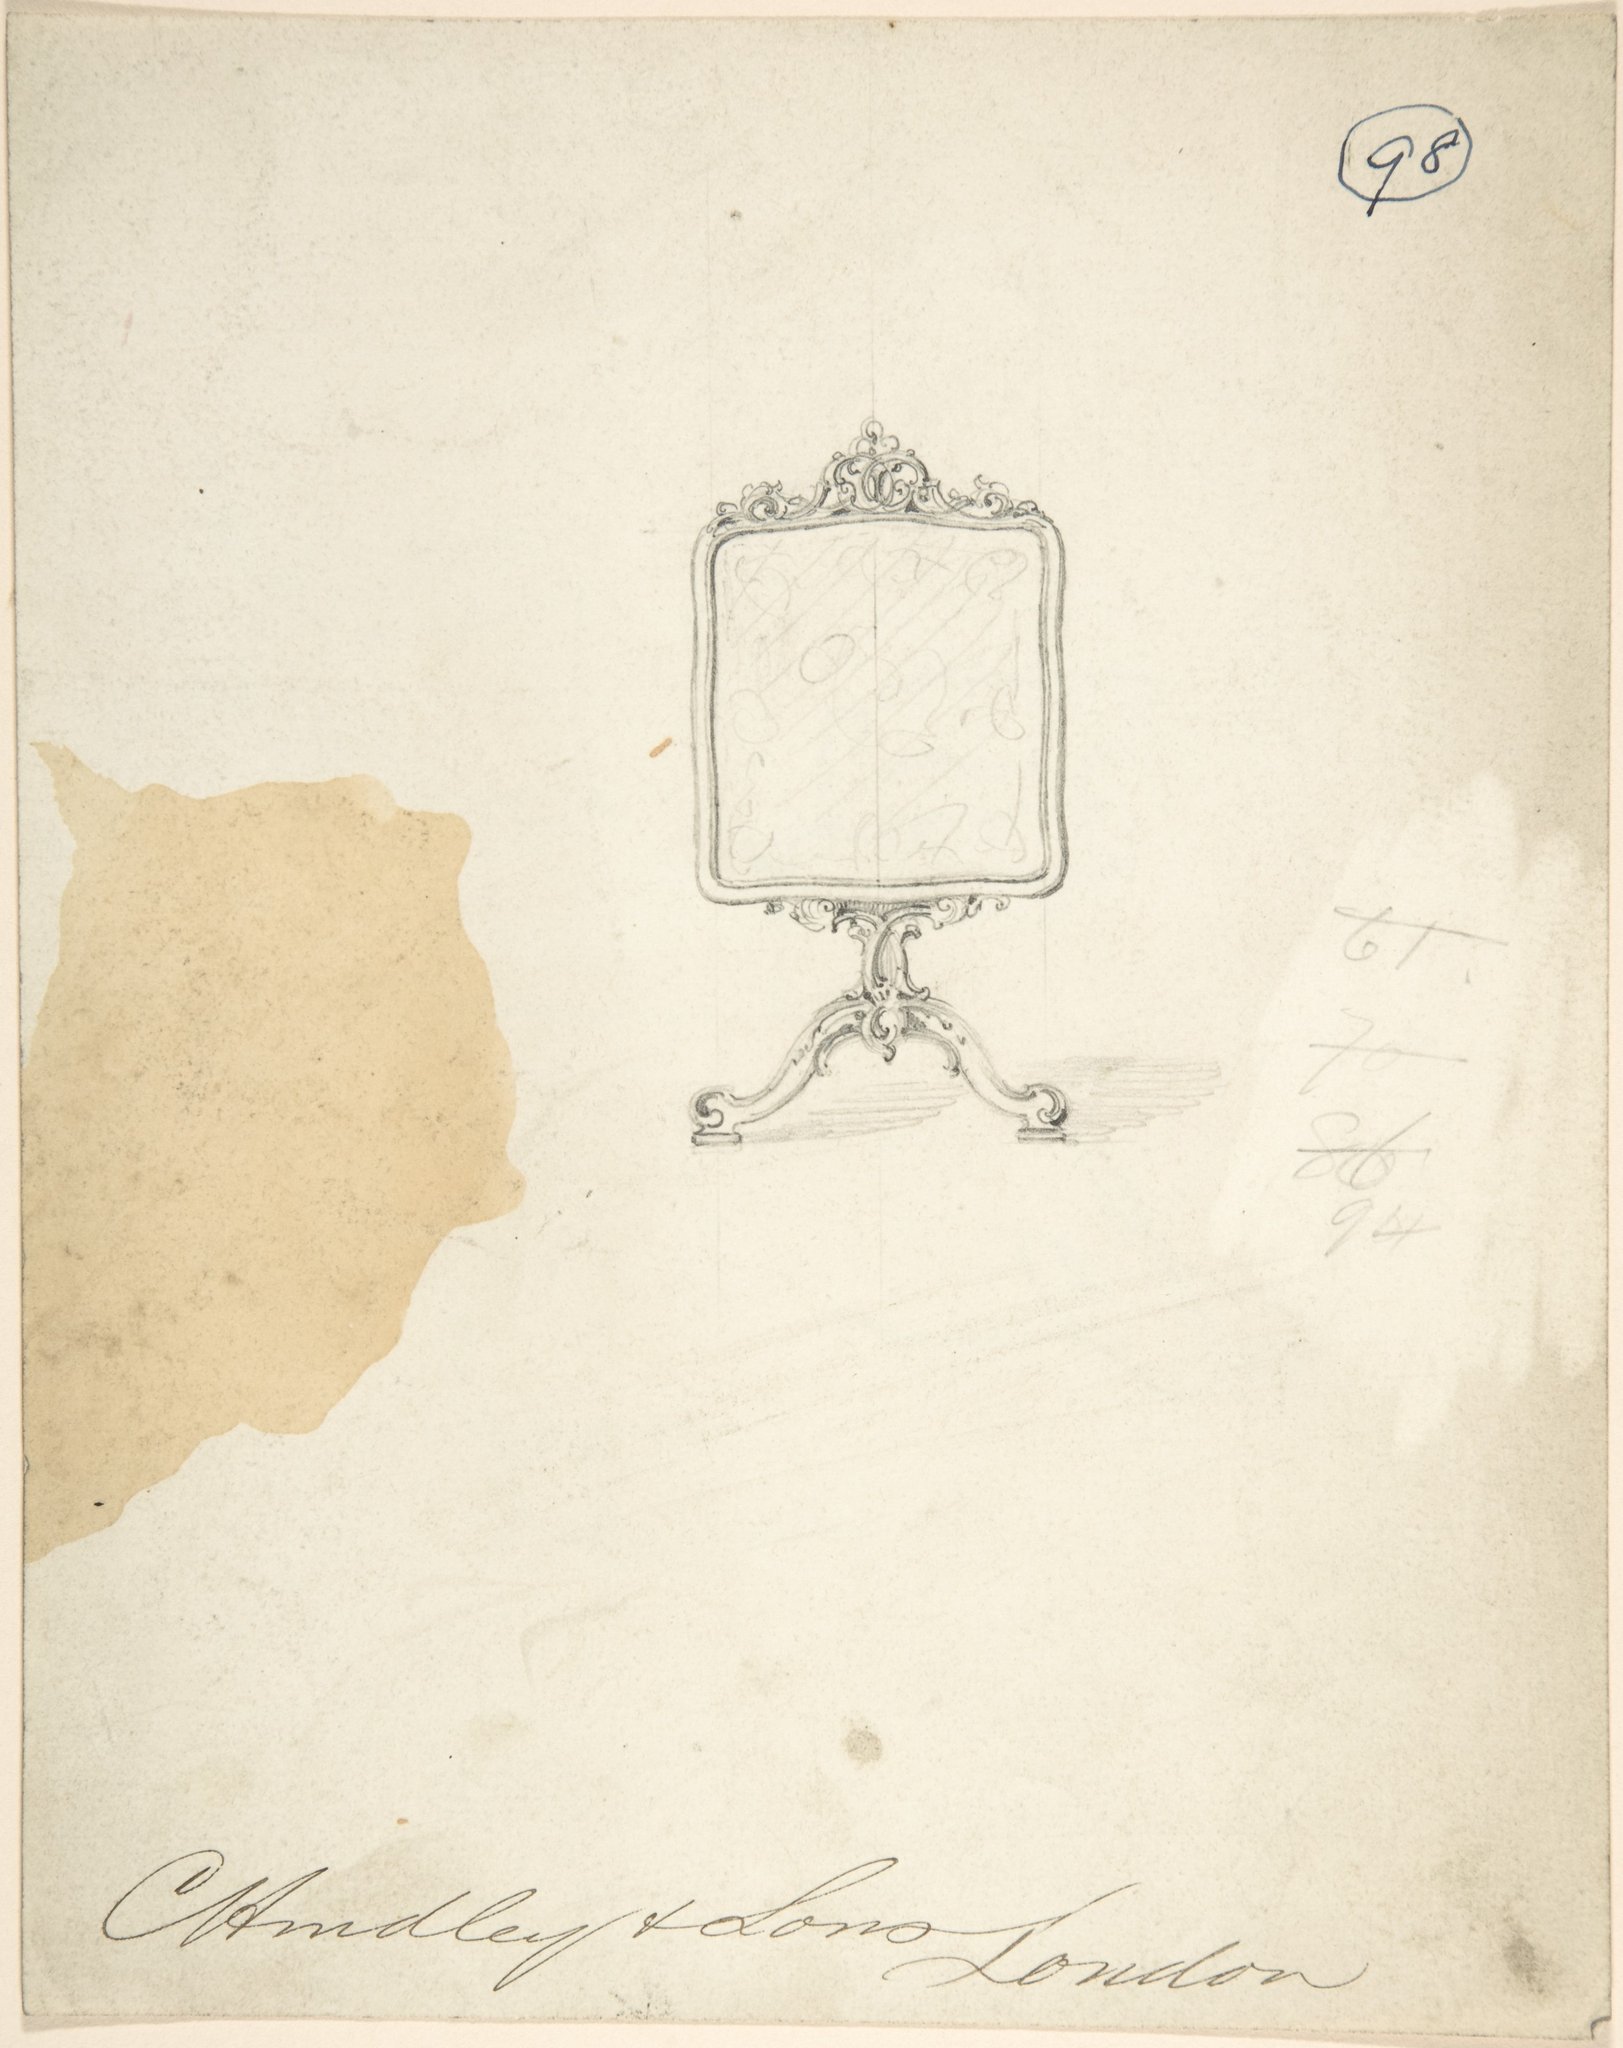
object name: drawing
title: Design for a Standing Frame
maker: charles hindley and sons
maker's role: artist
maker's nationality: british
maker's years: 1841-1917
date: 1841-1884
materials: graphite